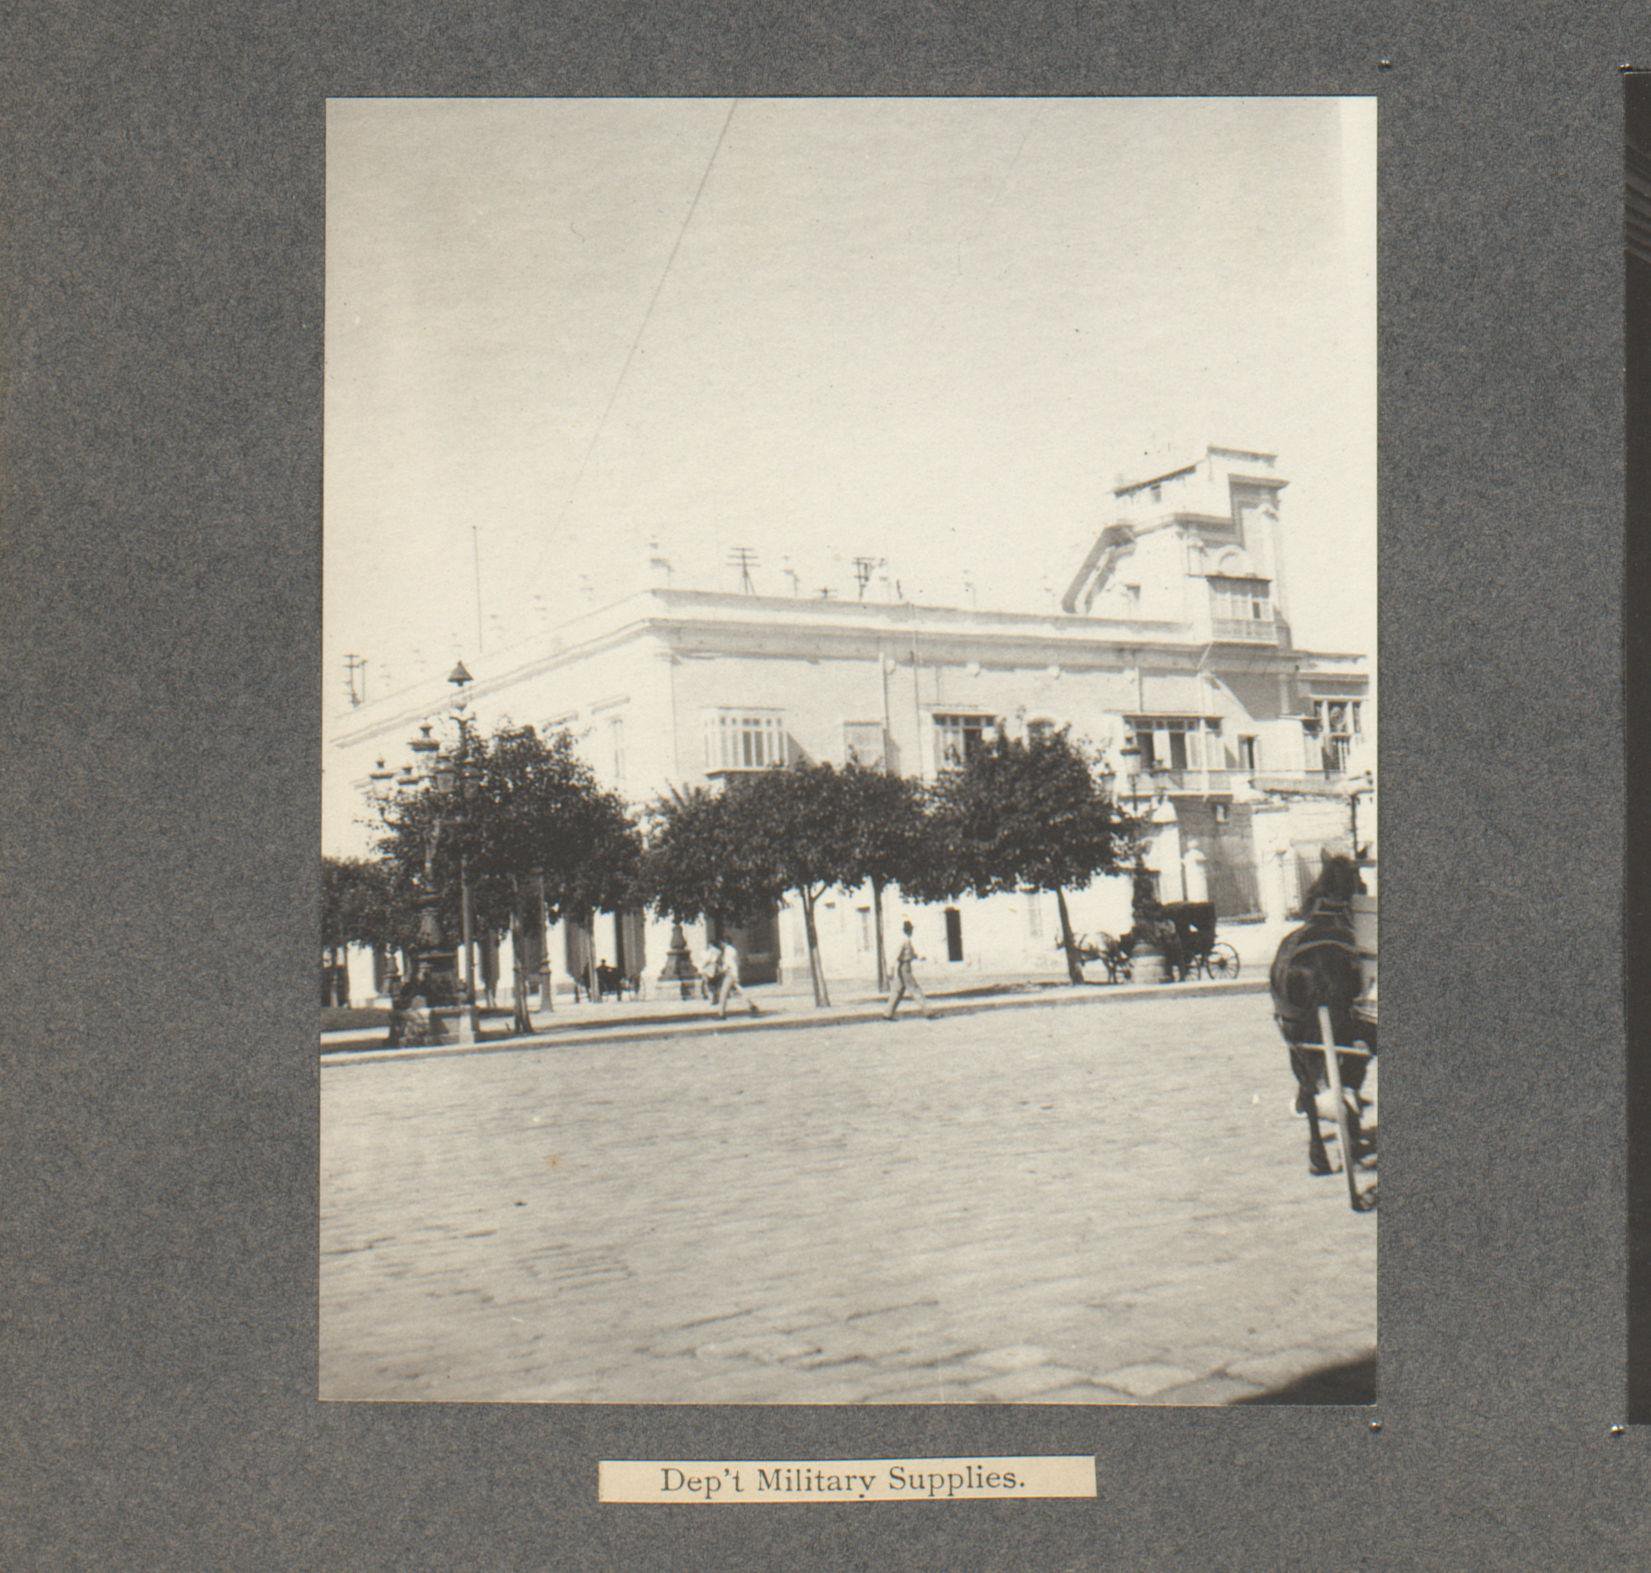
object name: album leaf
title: Havana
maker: Anonymous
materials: paper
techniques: platinum process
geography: havana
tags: exterior ~ representation of a building